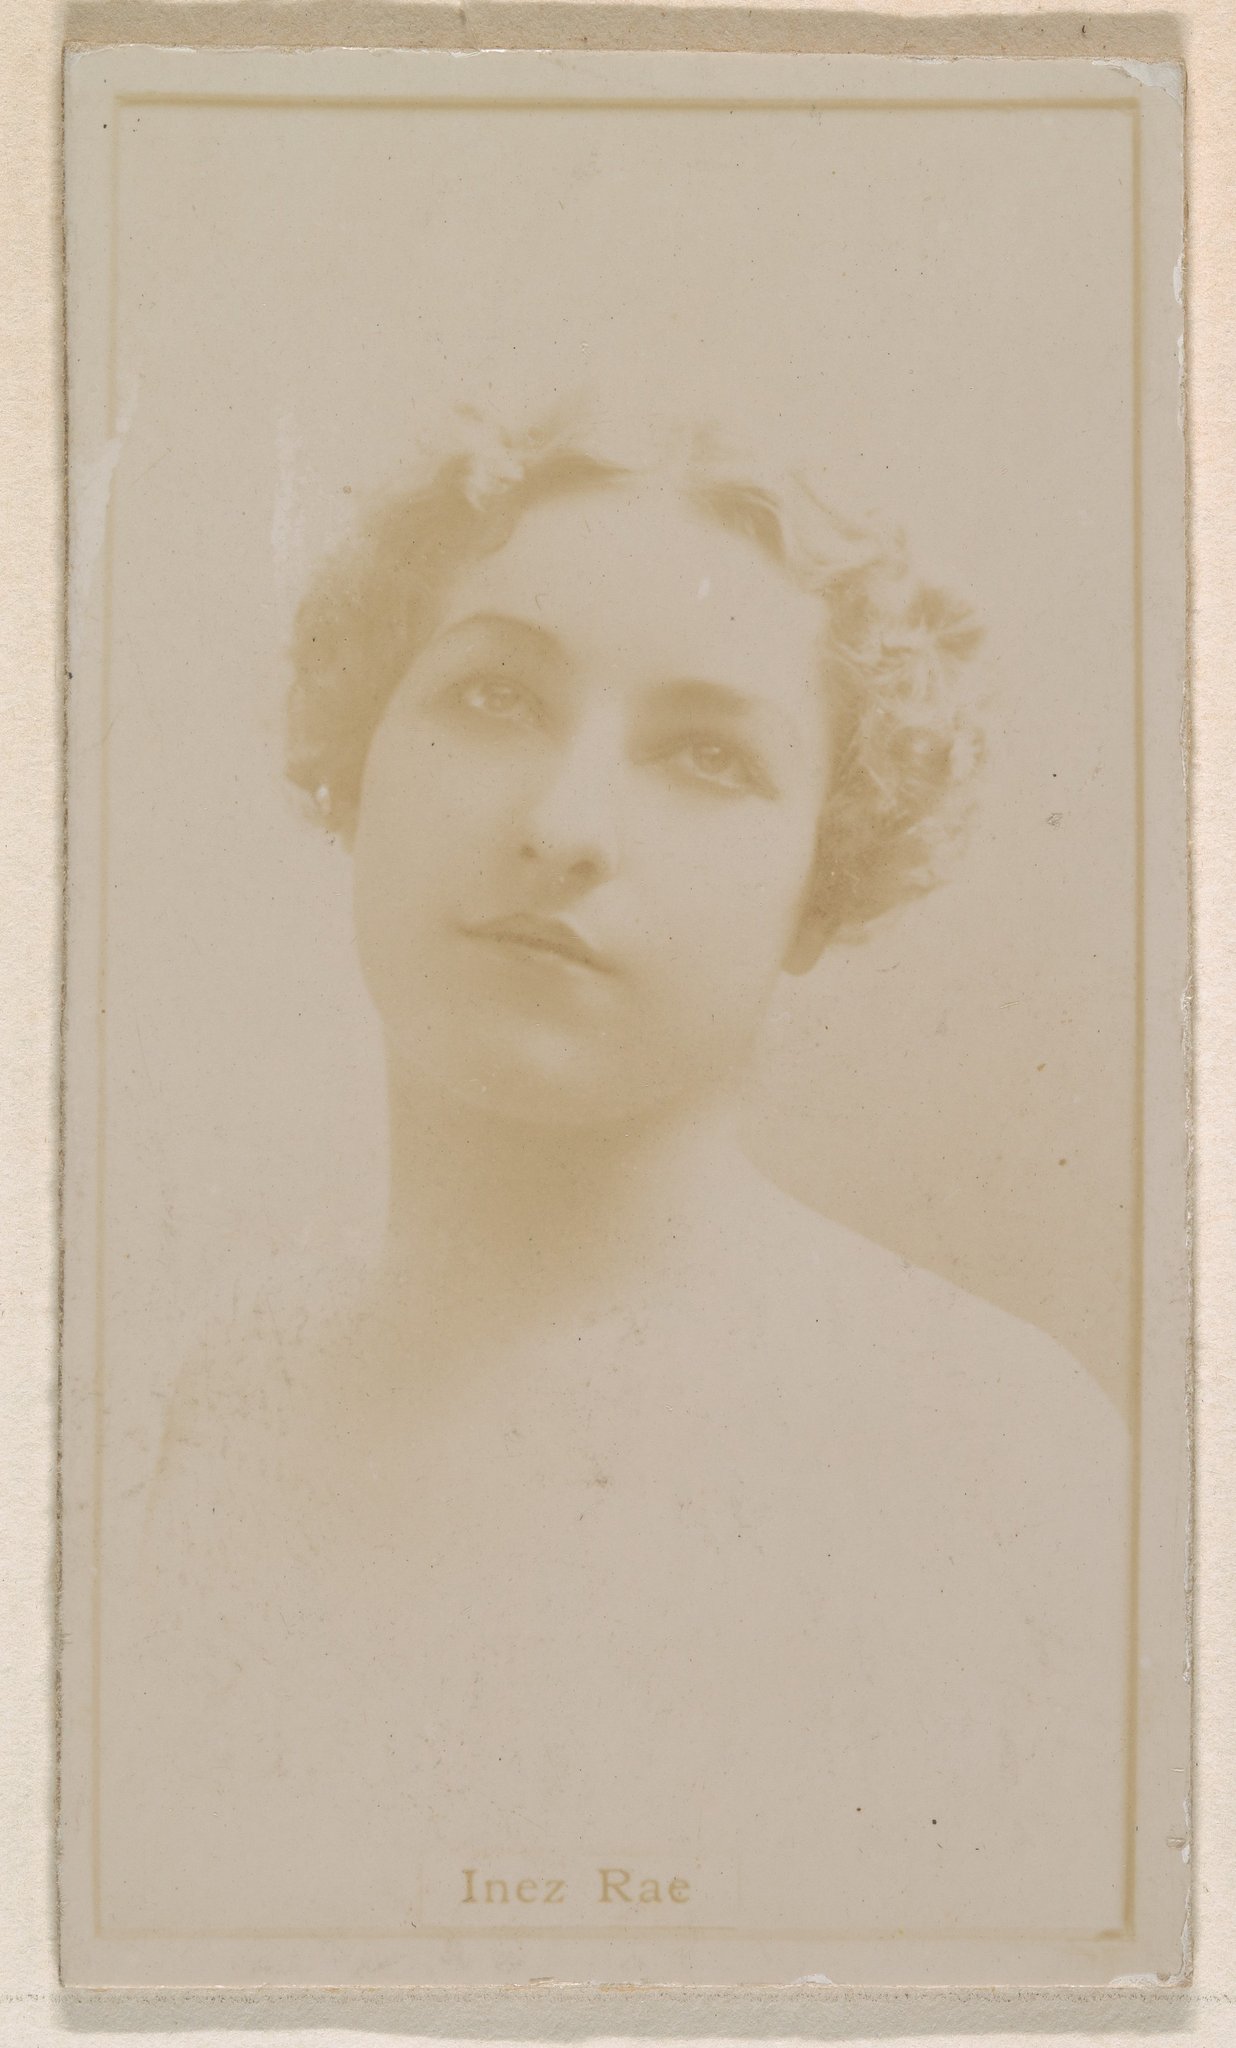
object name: photograph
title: Inez Rae, from the Actresses series (N245) issued by Kinney Brothers to promote Sweet Caporal Cigarettes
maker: kinney brothers tobacco company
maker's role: publisher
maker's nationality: american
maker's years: 1869-2011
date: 1890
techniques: albumen silver print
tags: portraits,women,actresses